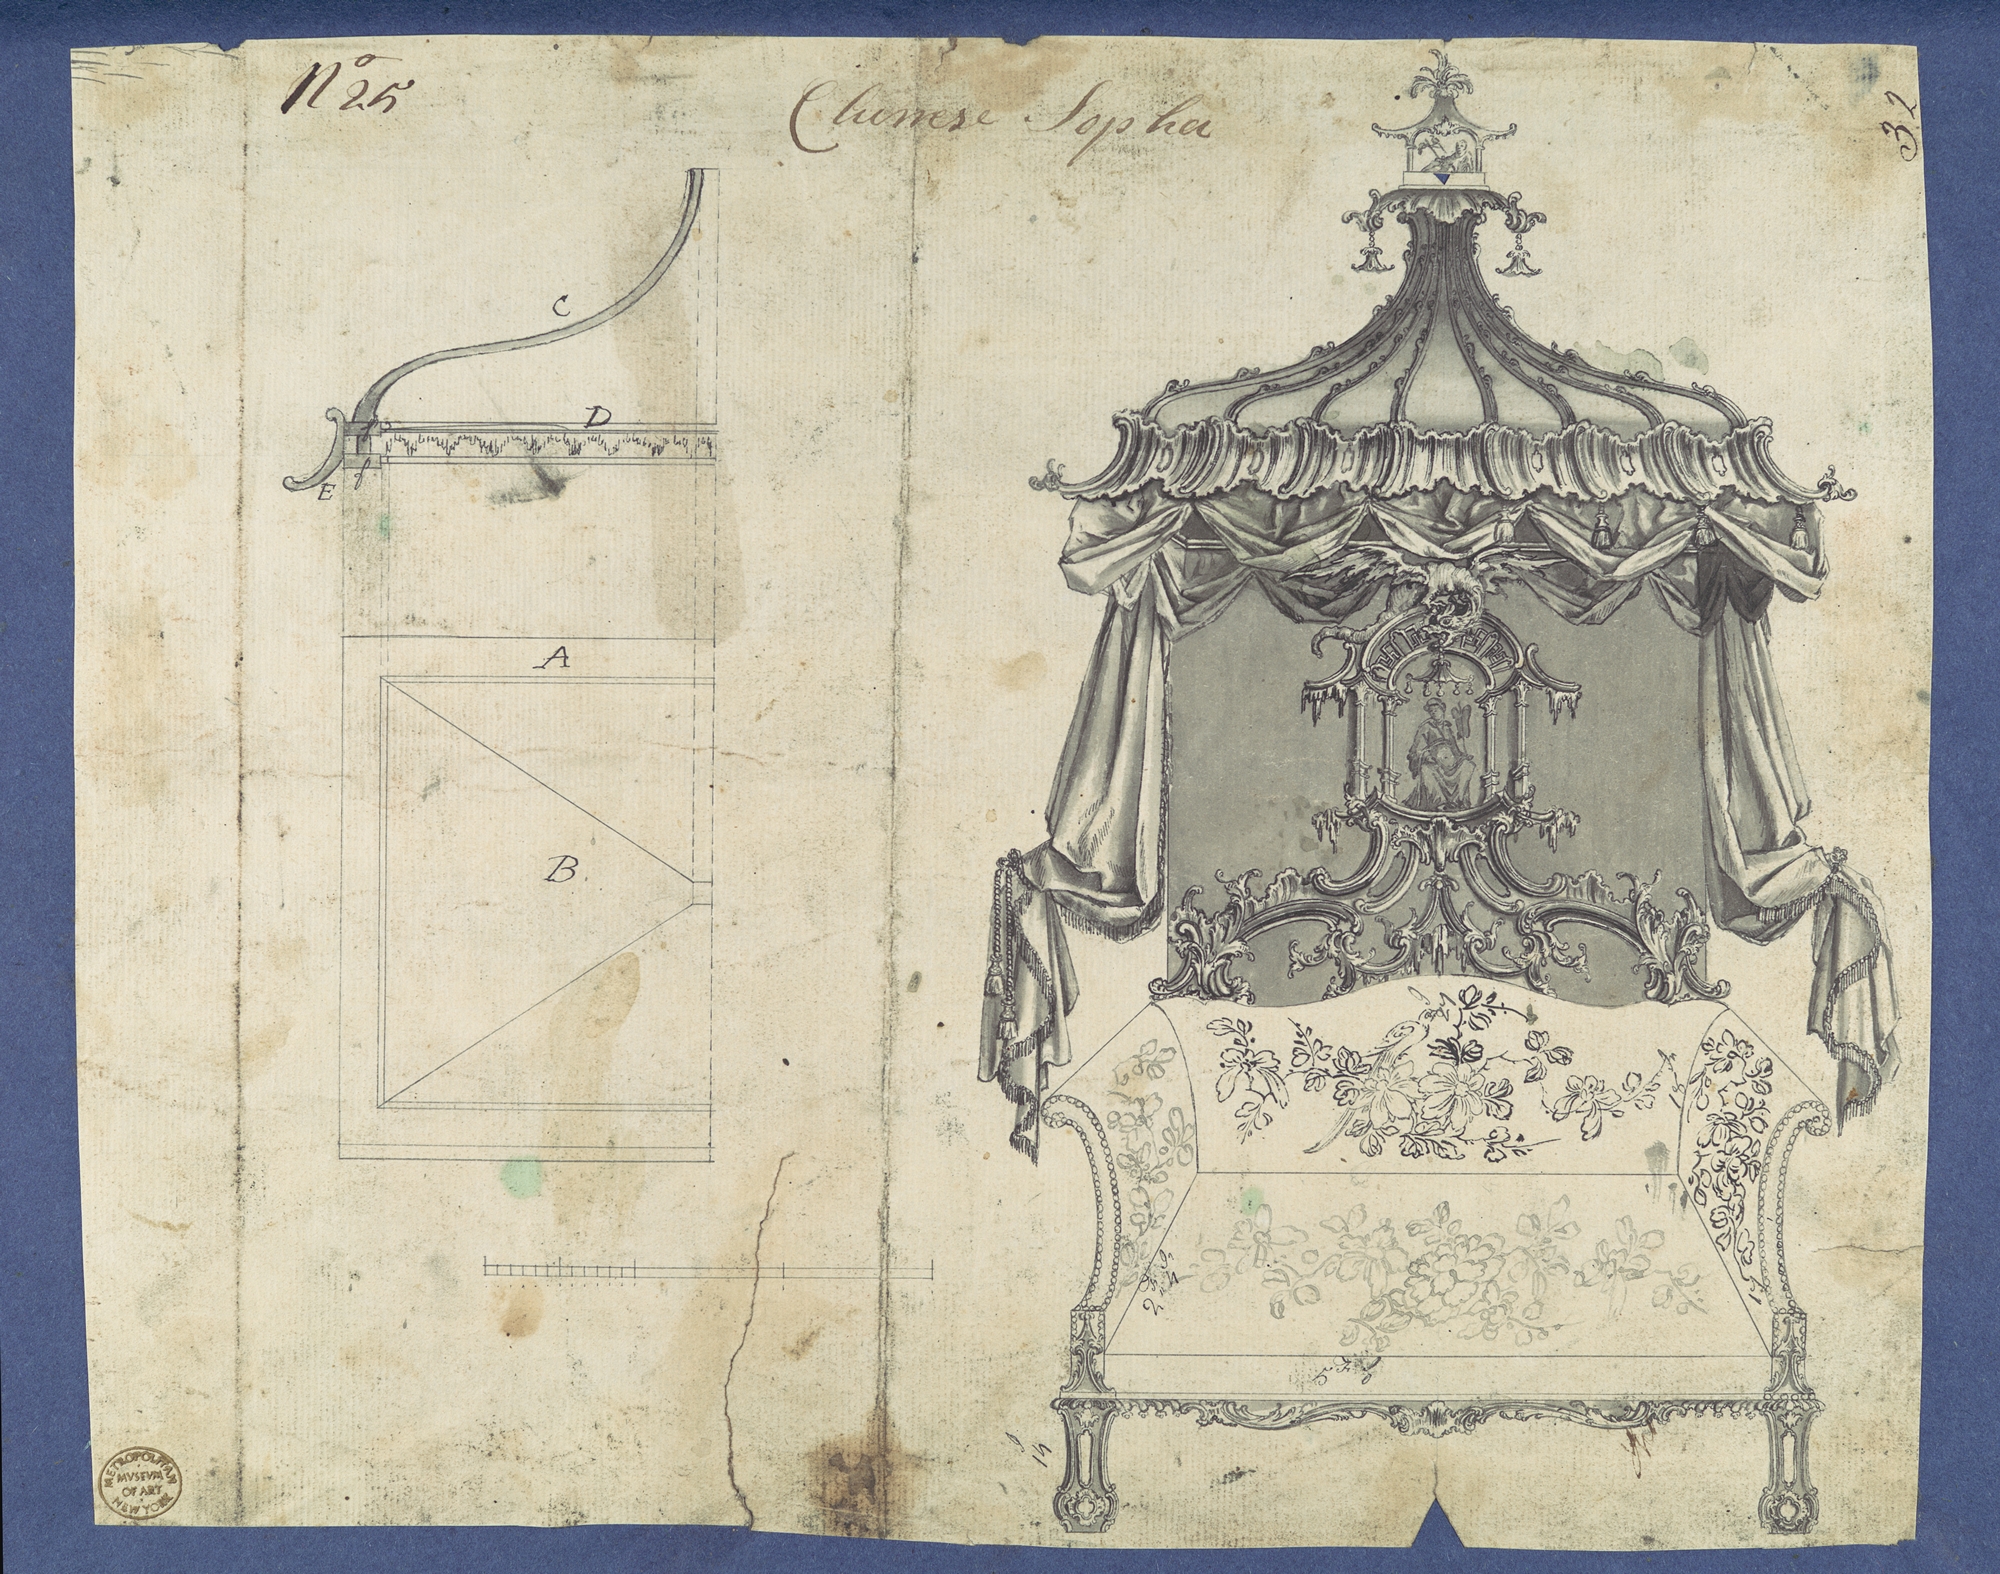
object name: drawing ornament architecture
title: Chinese Sopha [Sofa], in Chippendale Drawings, Vol. I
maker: thomas chippendale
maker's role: artist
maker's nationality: british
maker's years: 1718-1779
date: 1754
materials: ink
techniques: wash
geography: london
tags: furniture